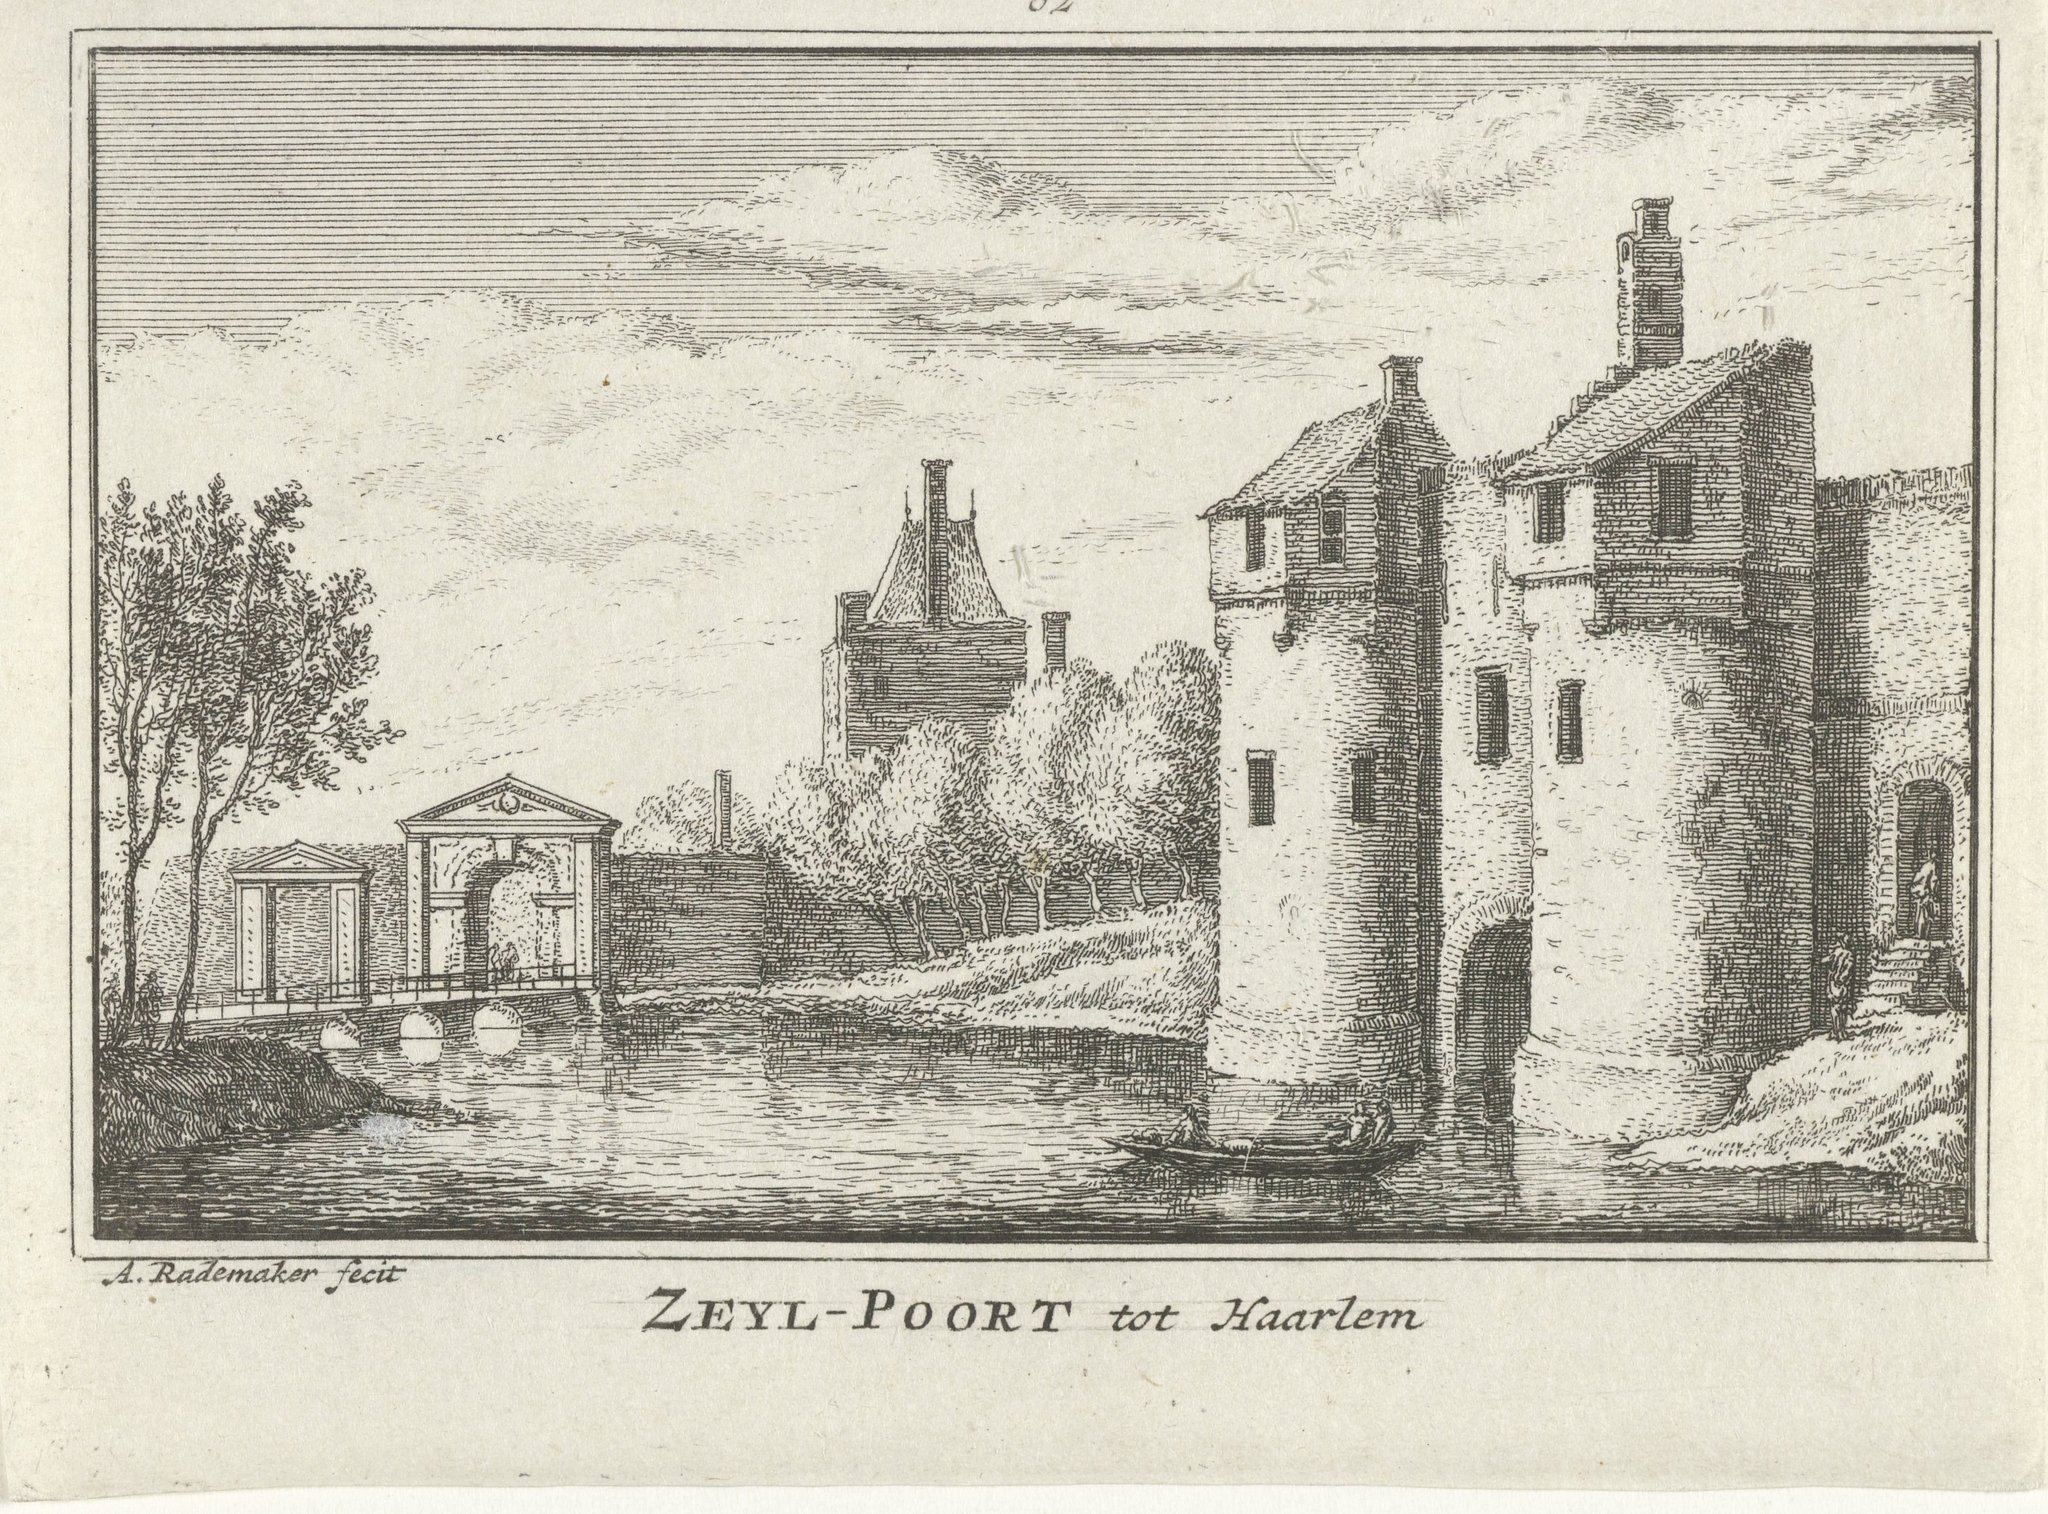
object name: book illustration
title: Zeyl-Poort tot Haarlem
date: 1727-1733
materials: paper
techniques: etching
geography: amsterdam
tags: rowing-boat, canoe, etc., city-gate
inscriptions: collector's mark: Lugt 2228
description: Illustratie uit: Abraham Rademaker, Matthaeus Brouërius van Niedek, Isaac Le Long, Kabinet van Nederlandsche en Kleefsche outheden en (...) voorname stads- en landgebouwen, Willem Barents en Antoni Schoonenburg: Amsterdam, 1727-1733, ill. nr. 62.